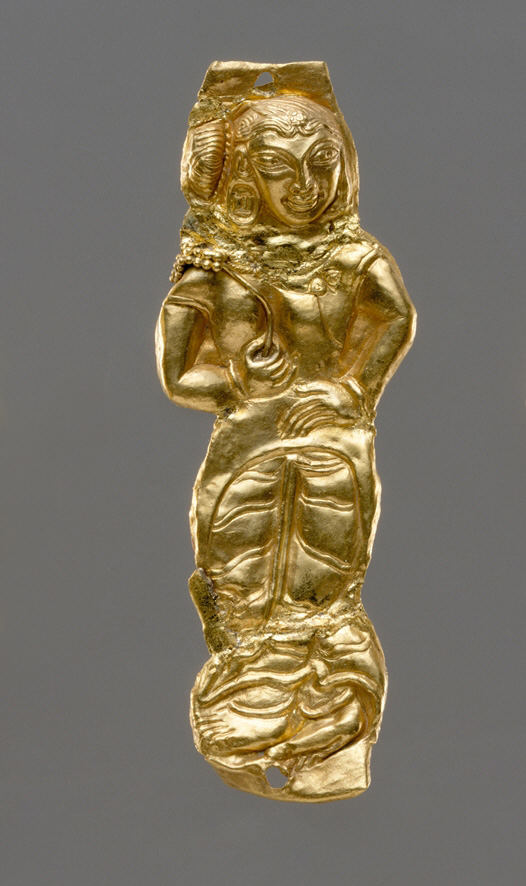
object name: figure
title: Standing Female Figure with an Offering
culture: indian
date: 1-200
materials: gold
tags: gandhara,women